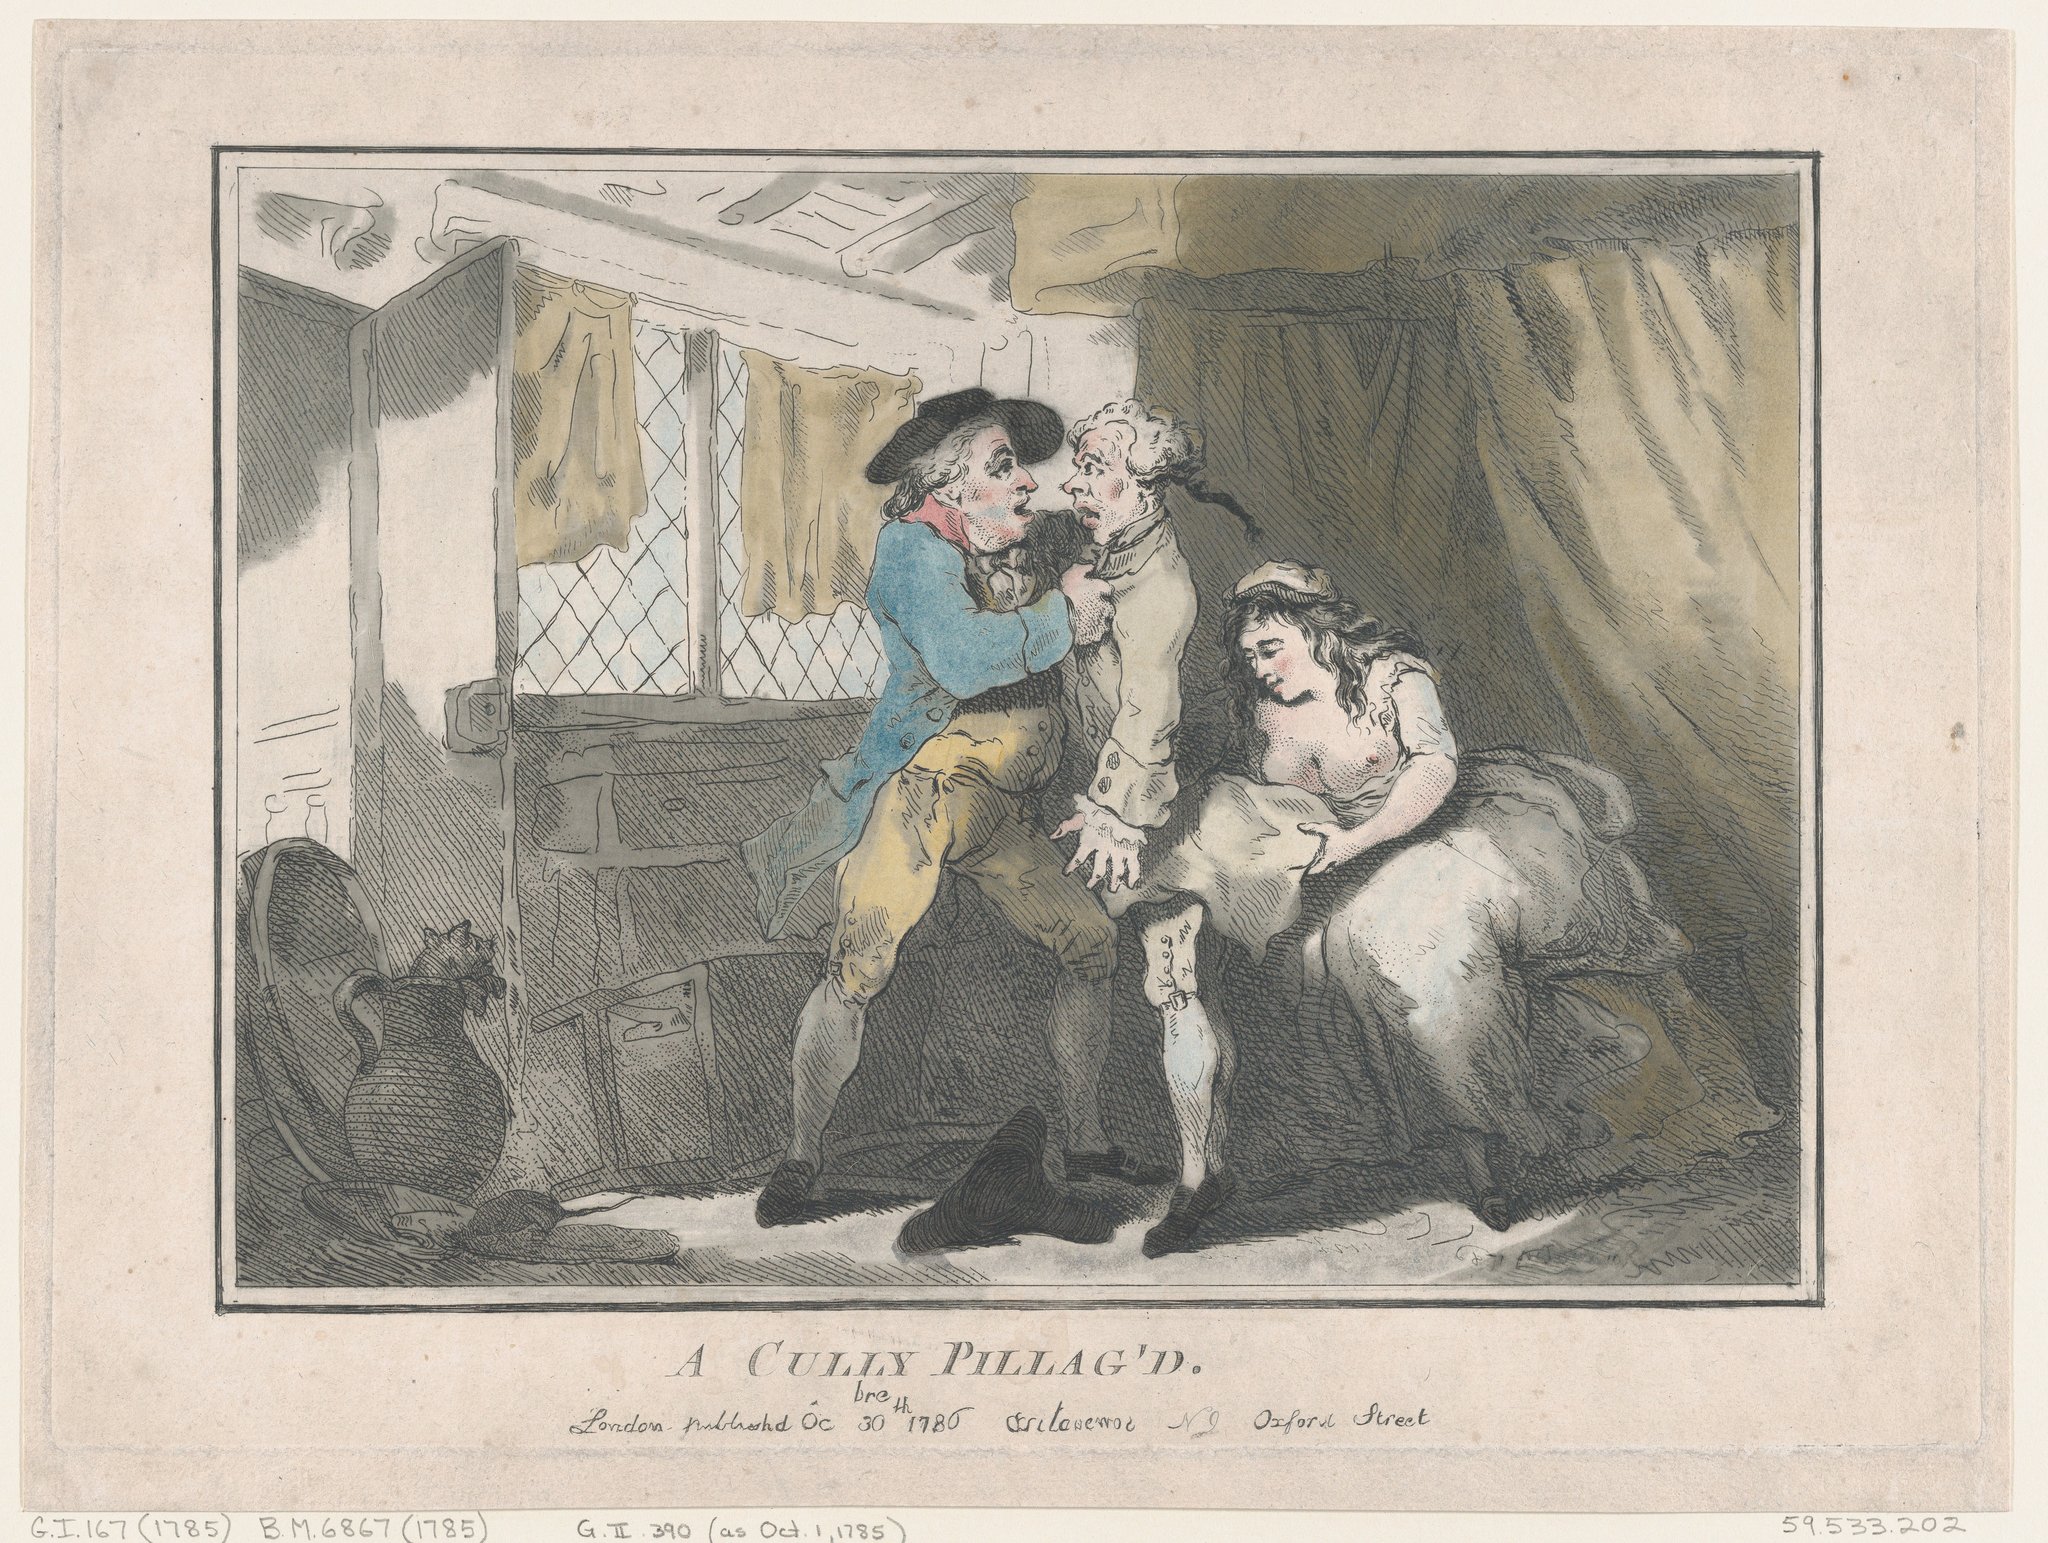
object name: print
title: A Cully Pillag'd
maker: thomas rowlandson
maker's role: artist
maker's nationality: british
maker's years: 1757-1827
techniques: etching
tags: men,women